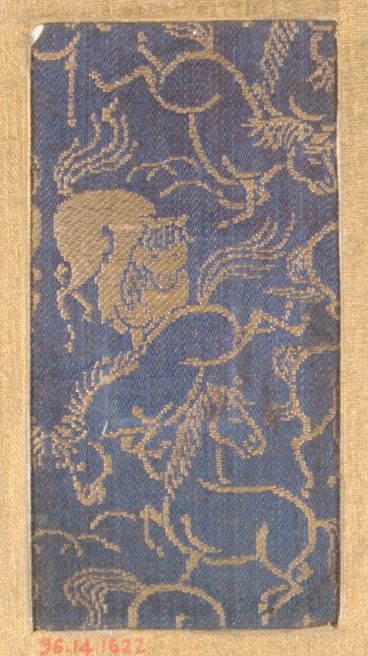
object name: piece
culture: japanese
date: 1701-1900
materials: silk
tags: horses